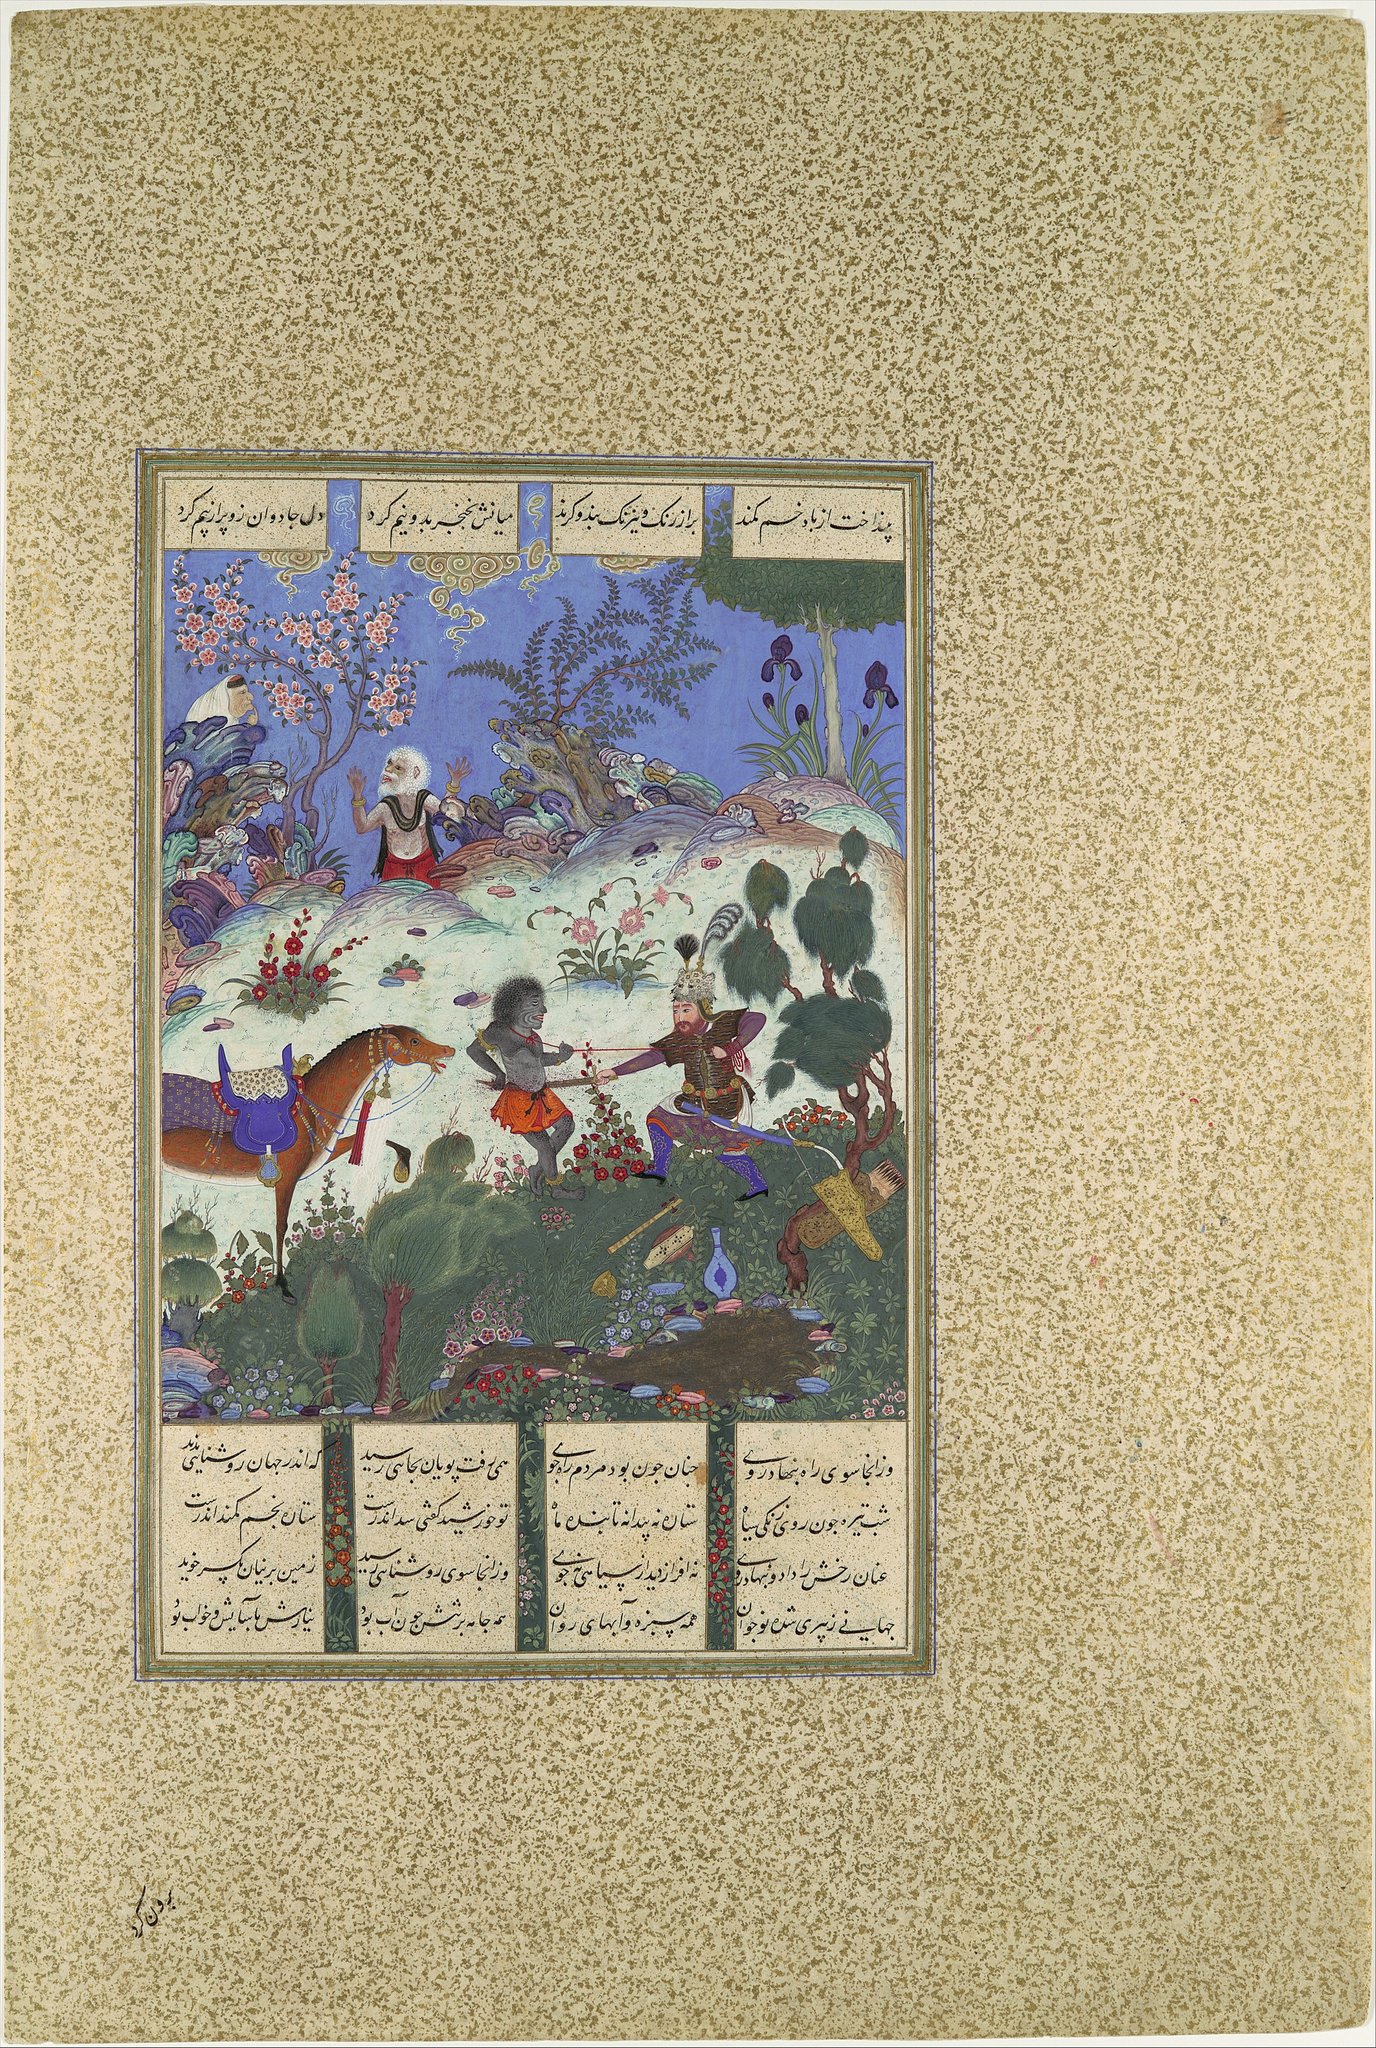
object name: folio from an illustrated manuscript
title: "Rustam's Fourth Course, He Cleaves a Witch", Folio 120v from the Shahnama (Book of Kings) of Shah Tahmasp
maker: abu'l qasim firdausi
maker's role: author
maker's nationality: iranian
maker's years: 935-1020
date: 1525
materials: gold, ink, paper, silver, watercolor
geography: iran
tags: poetry,men,horses